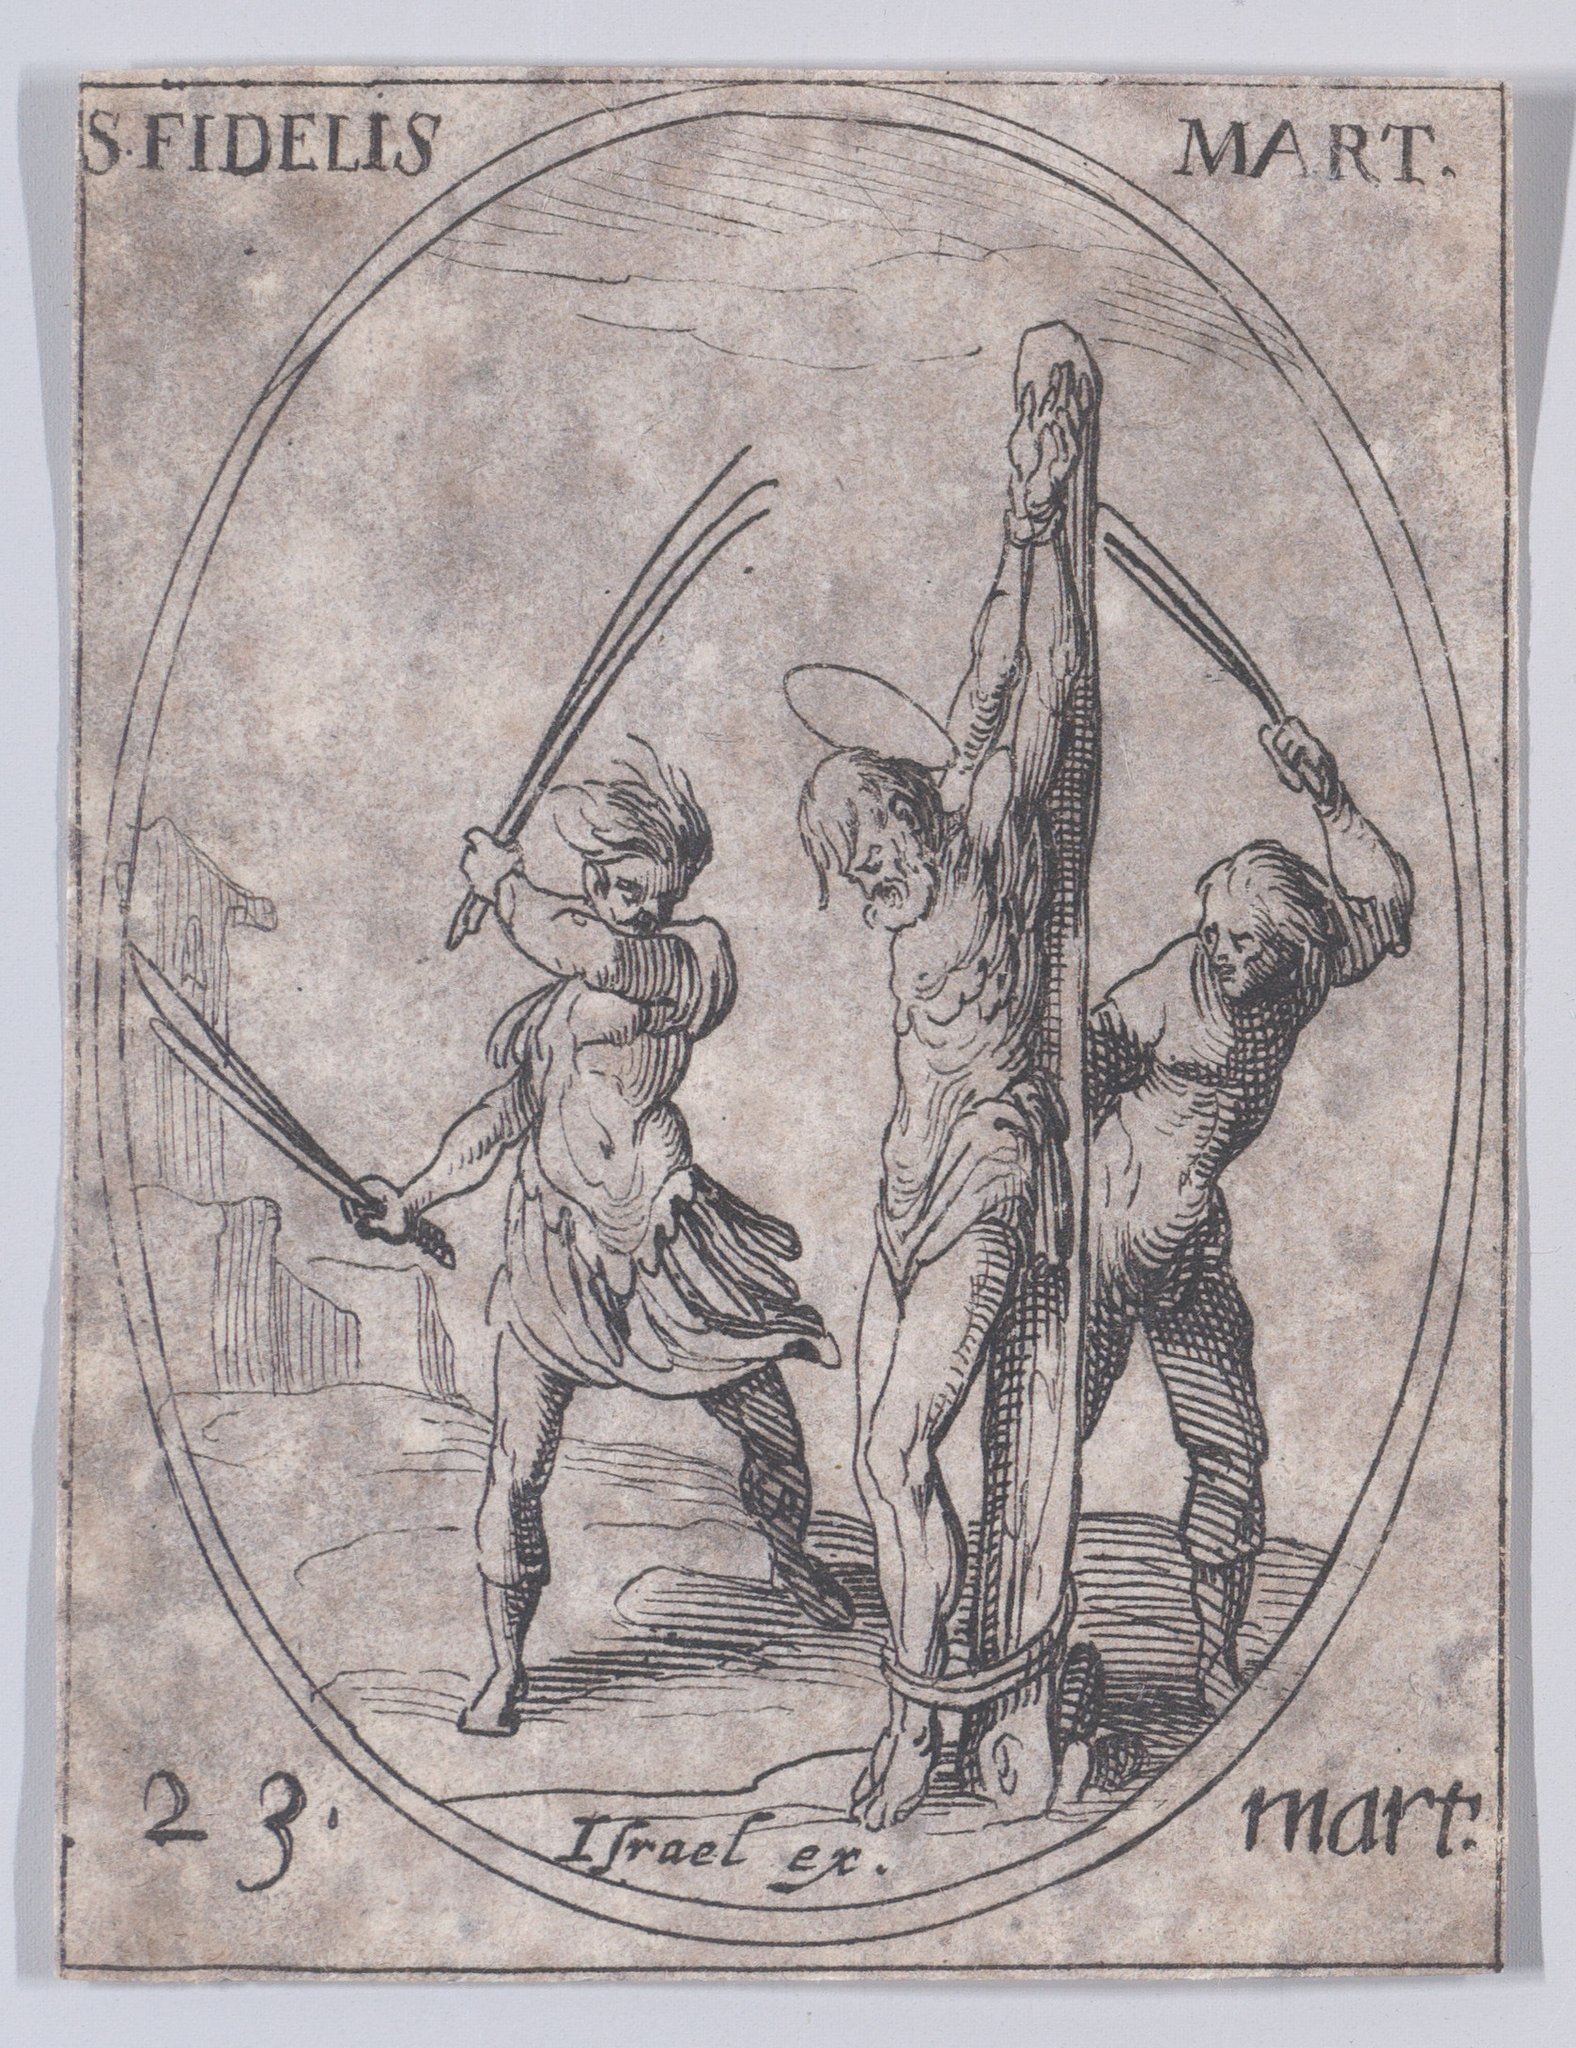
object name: print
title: S. Fidèle, martyr (St. Fideles, Martyr), March 23rd, from "Les Images De Tous Les Saincts et Saintes de L'Année" (Images of All of the Saints and Religious Events of the Year)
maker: jacques callot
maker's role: artist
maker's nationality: french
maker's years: 1592-1635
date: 1636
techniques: etching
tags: men,saints